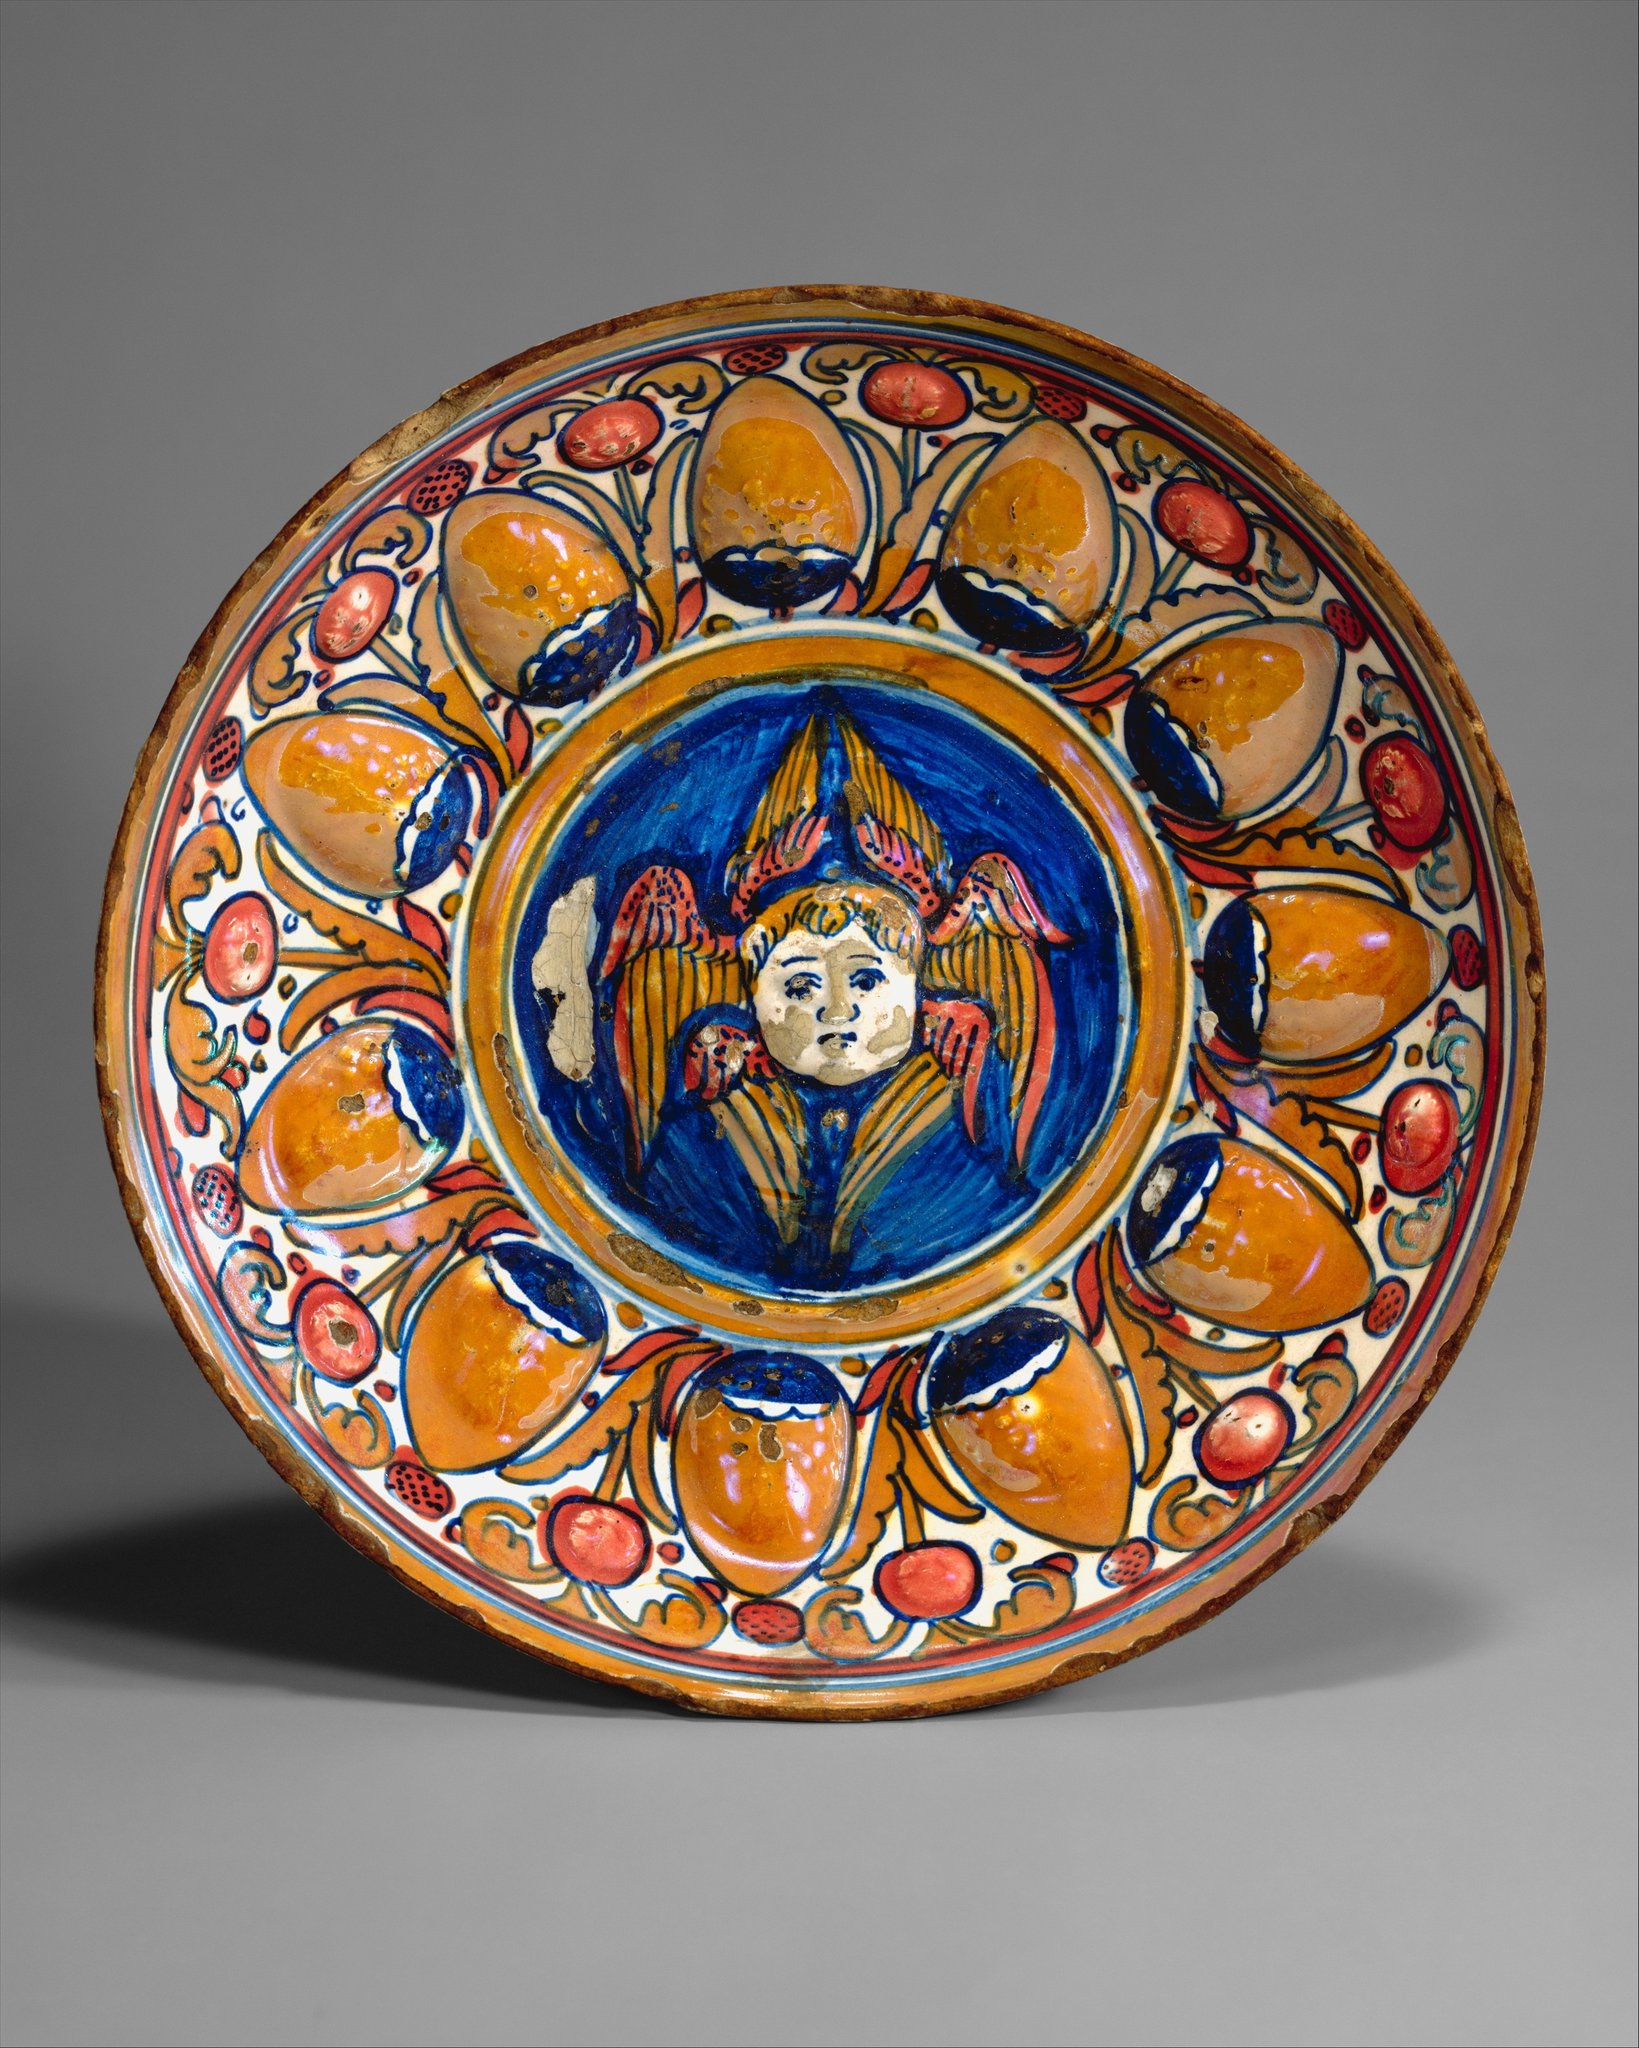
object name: dish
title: Dish (coppa)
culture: italian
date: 1530-1535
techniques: maiolica, glazing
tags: putti